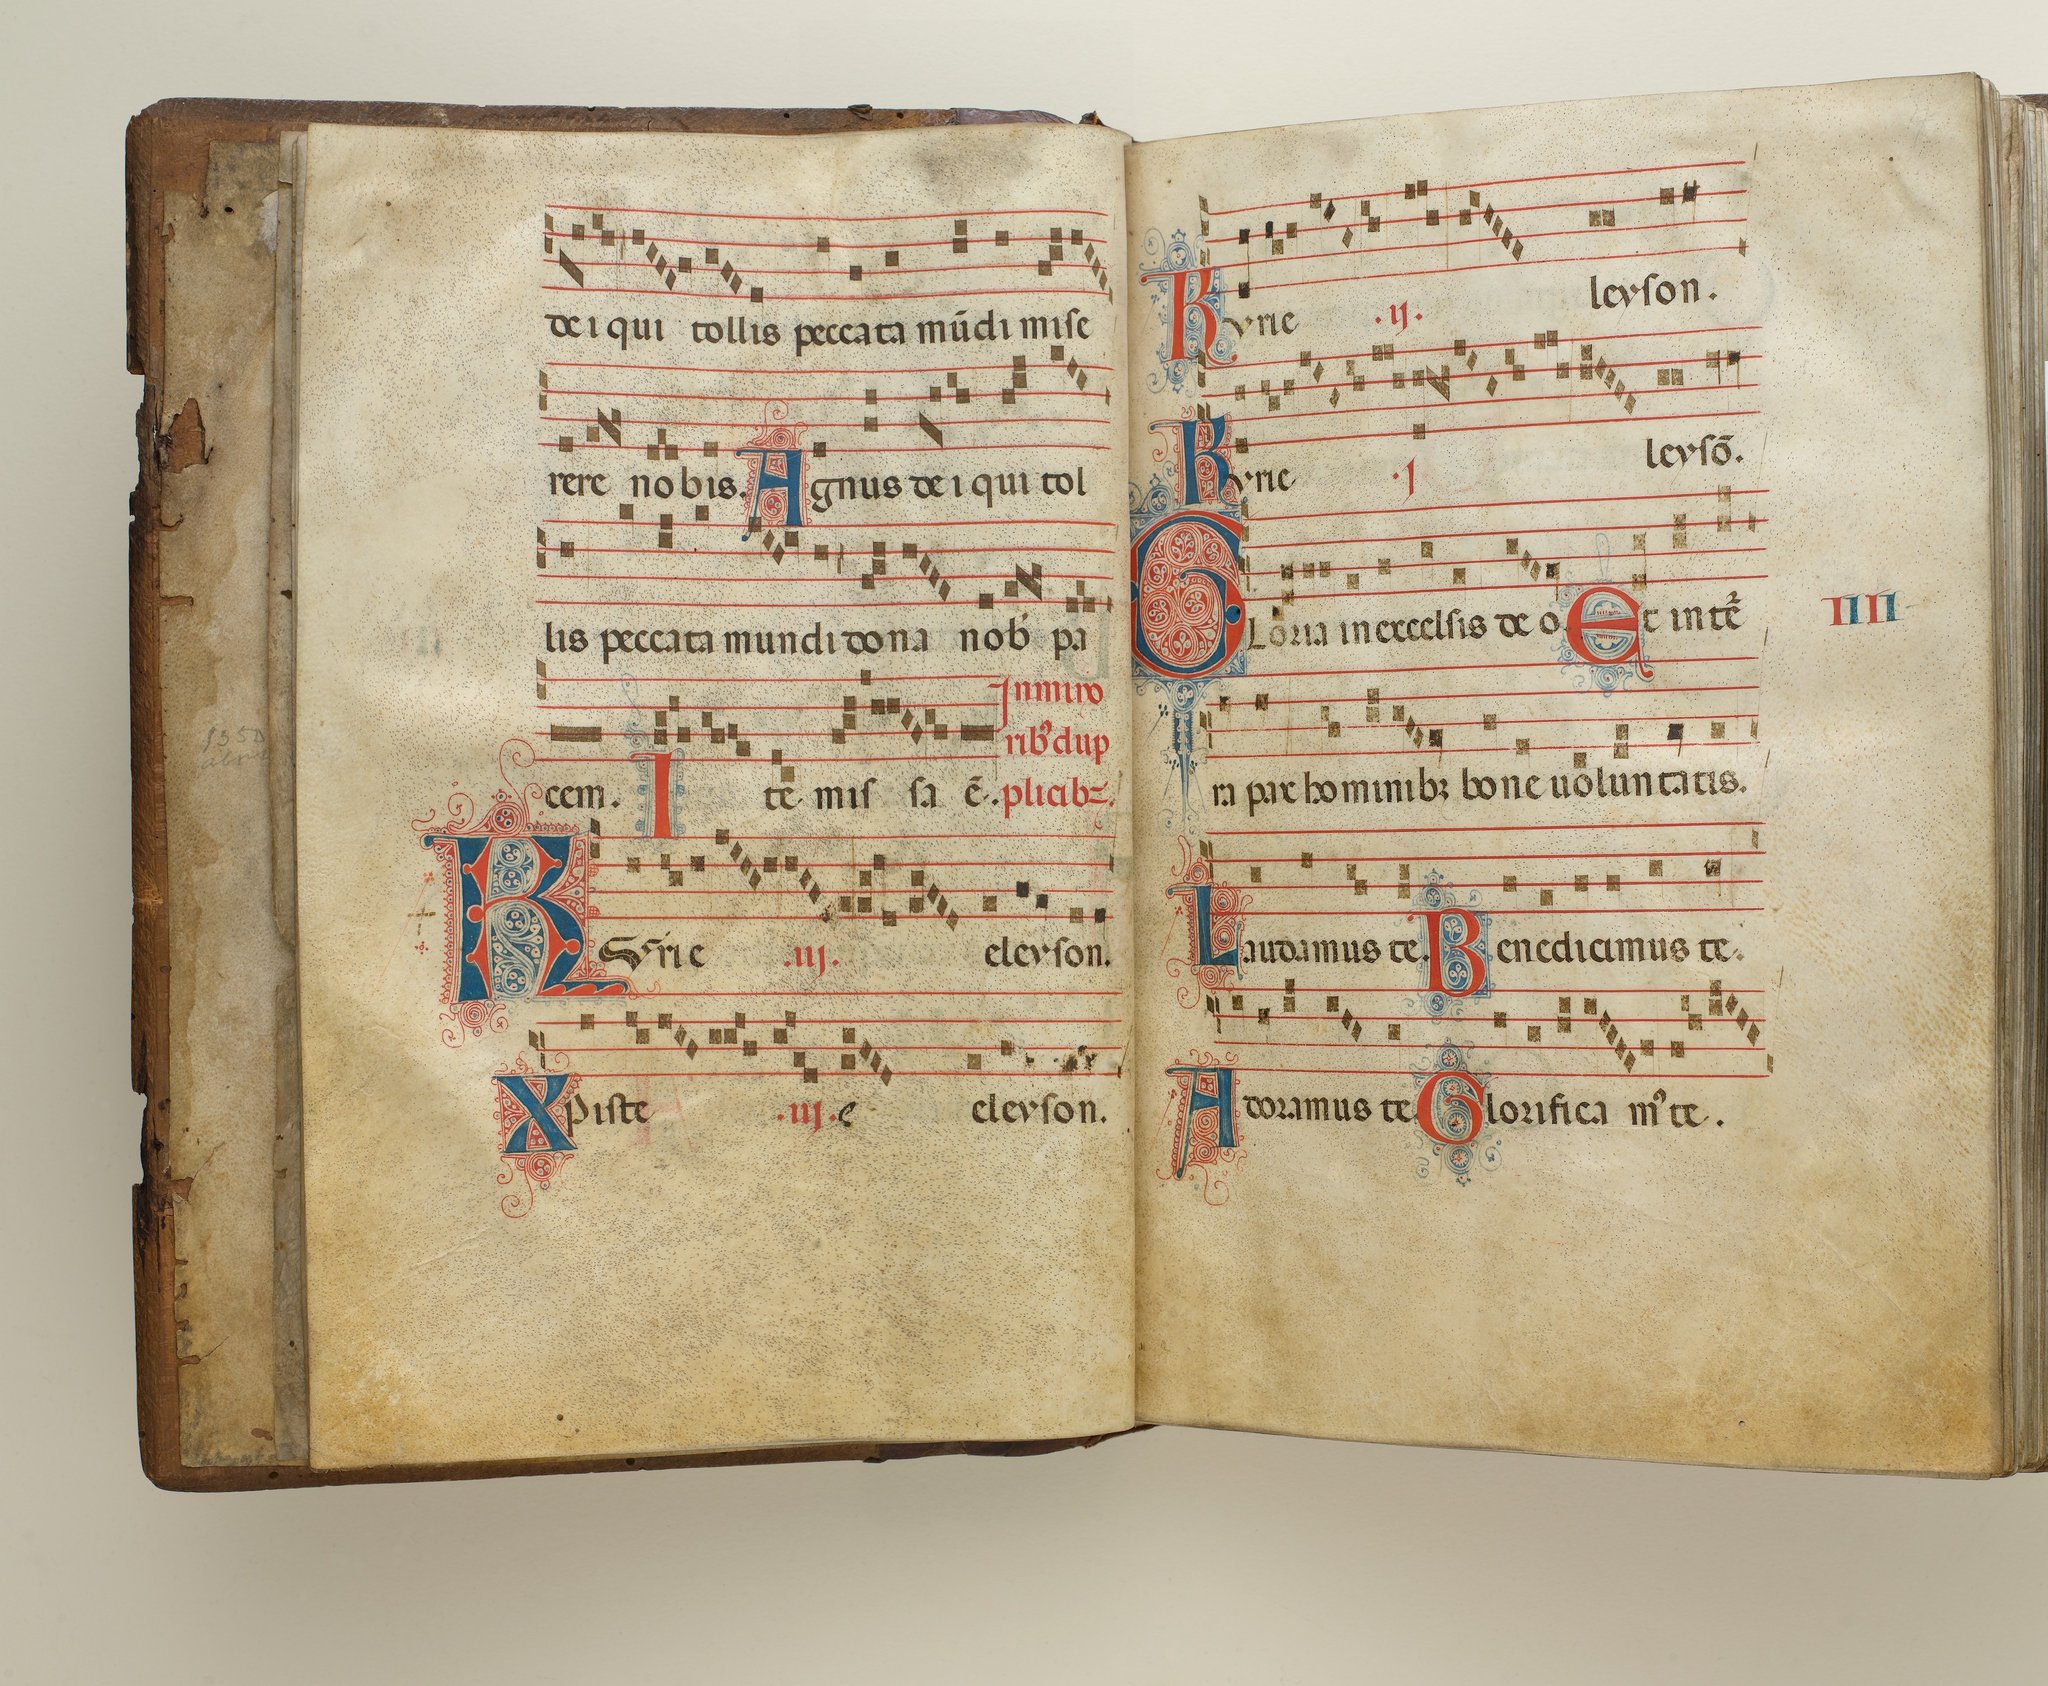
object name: gradual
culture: italian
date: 1310-1315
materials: ink, leather, wood, parchment, paint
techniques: bookbinding, tooling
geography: italy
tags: music